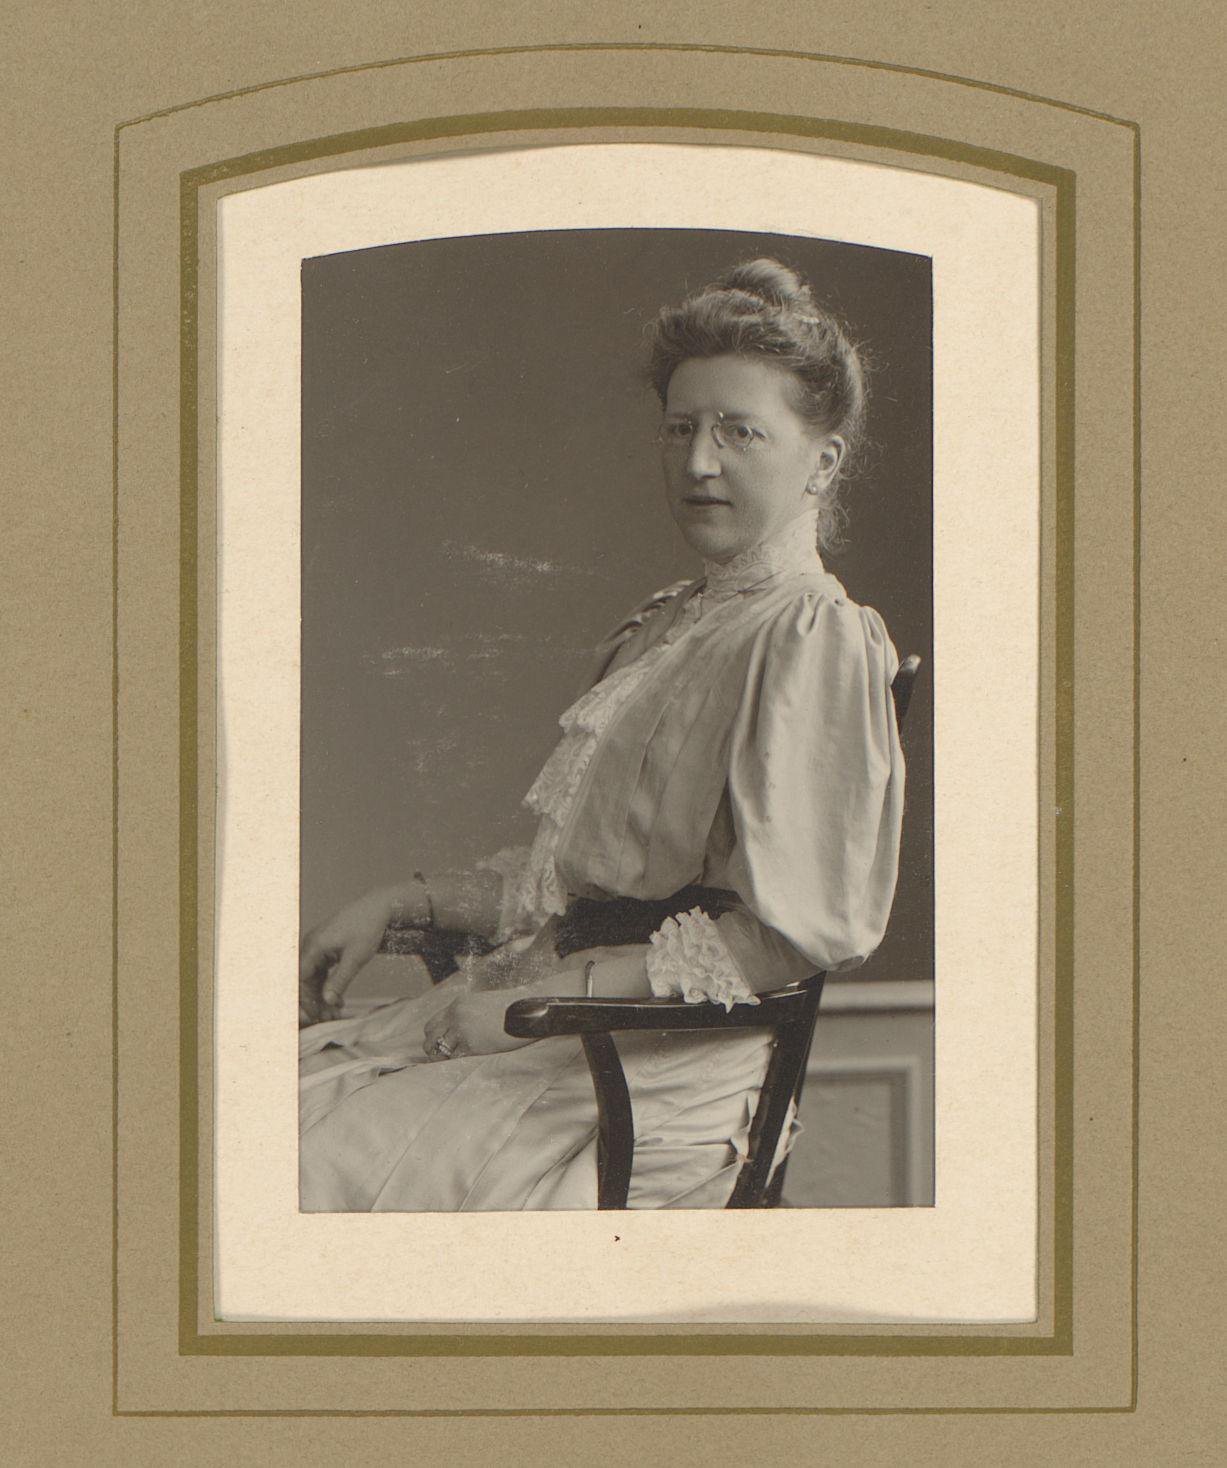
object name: album leaf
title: Portret van een vrouw met bril op een stoel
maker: Anonymous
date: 1895-1920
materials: cardboard, photographic support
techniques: matte daylight collodion silver print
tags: eyeglasses, spectacles, historical persons - bb - woman, chair